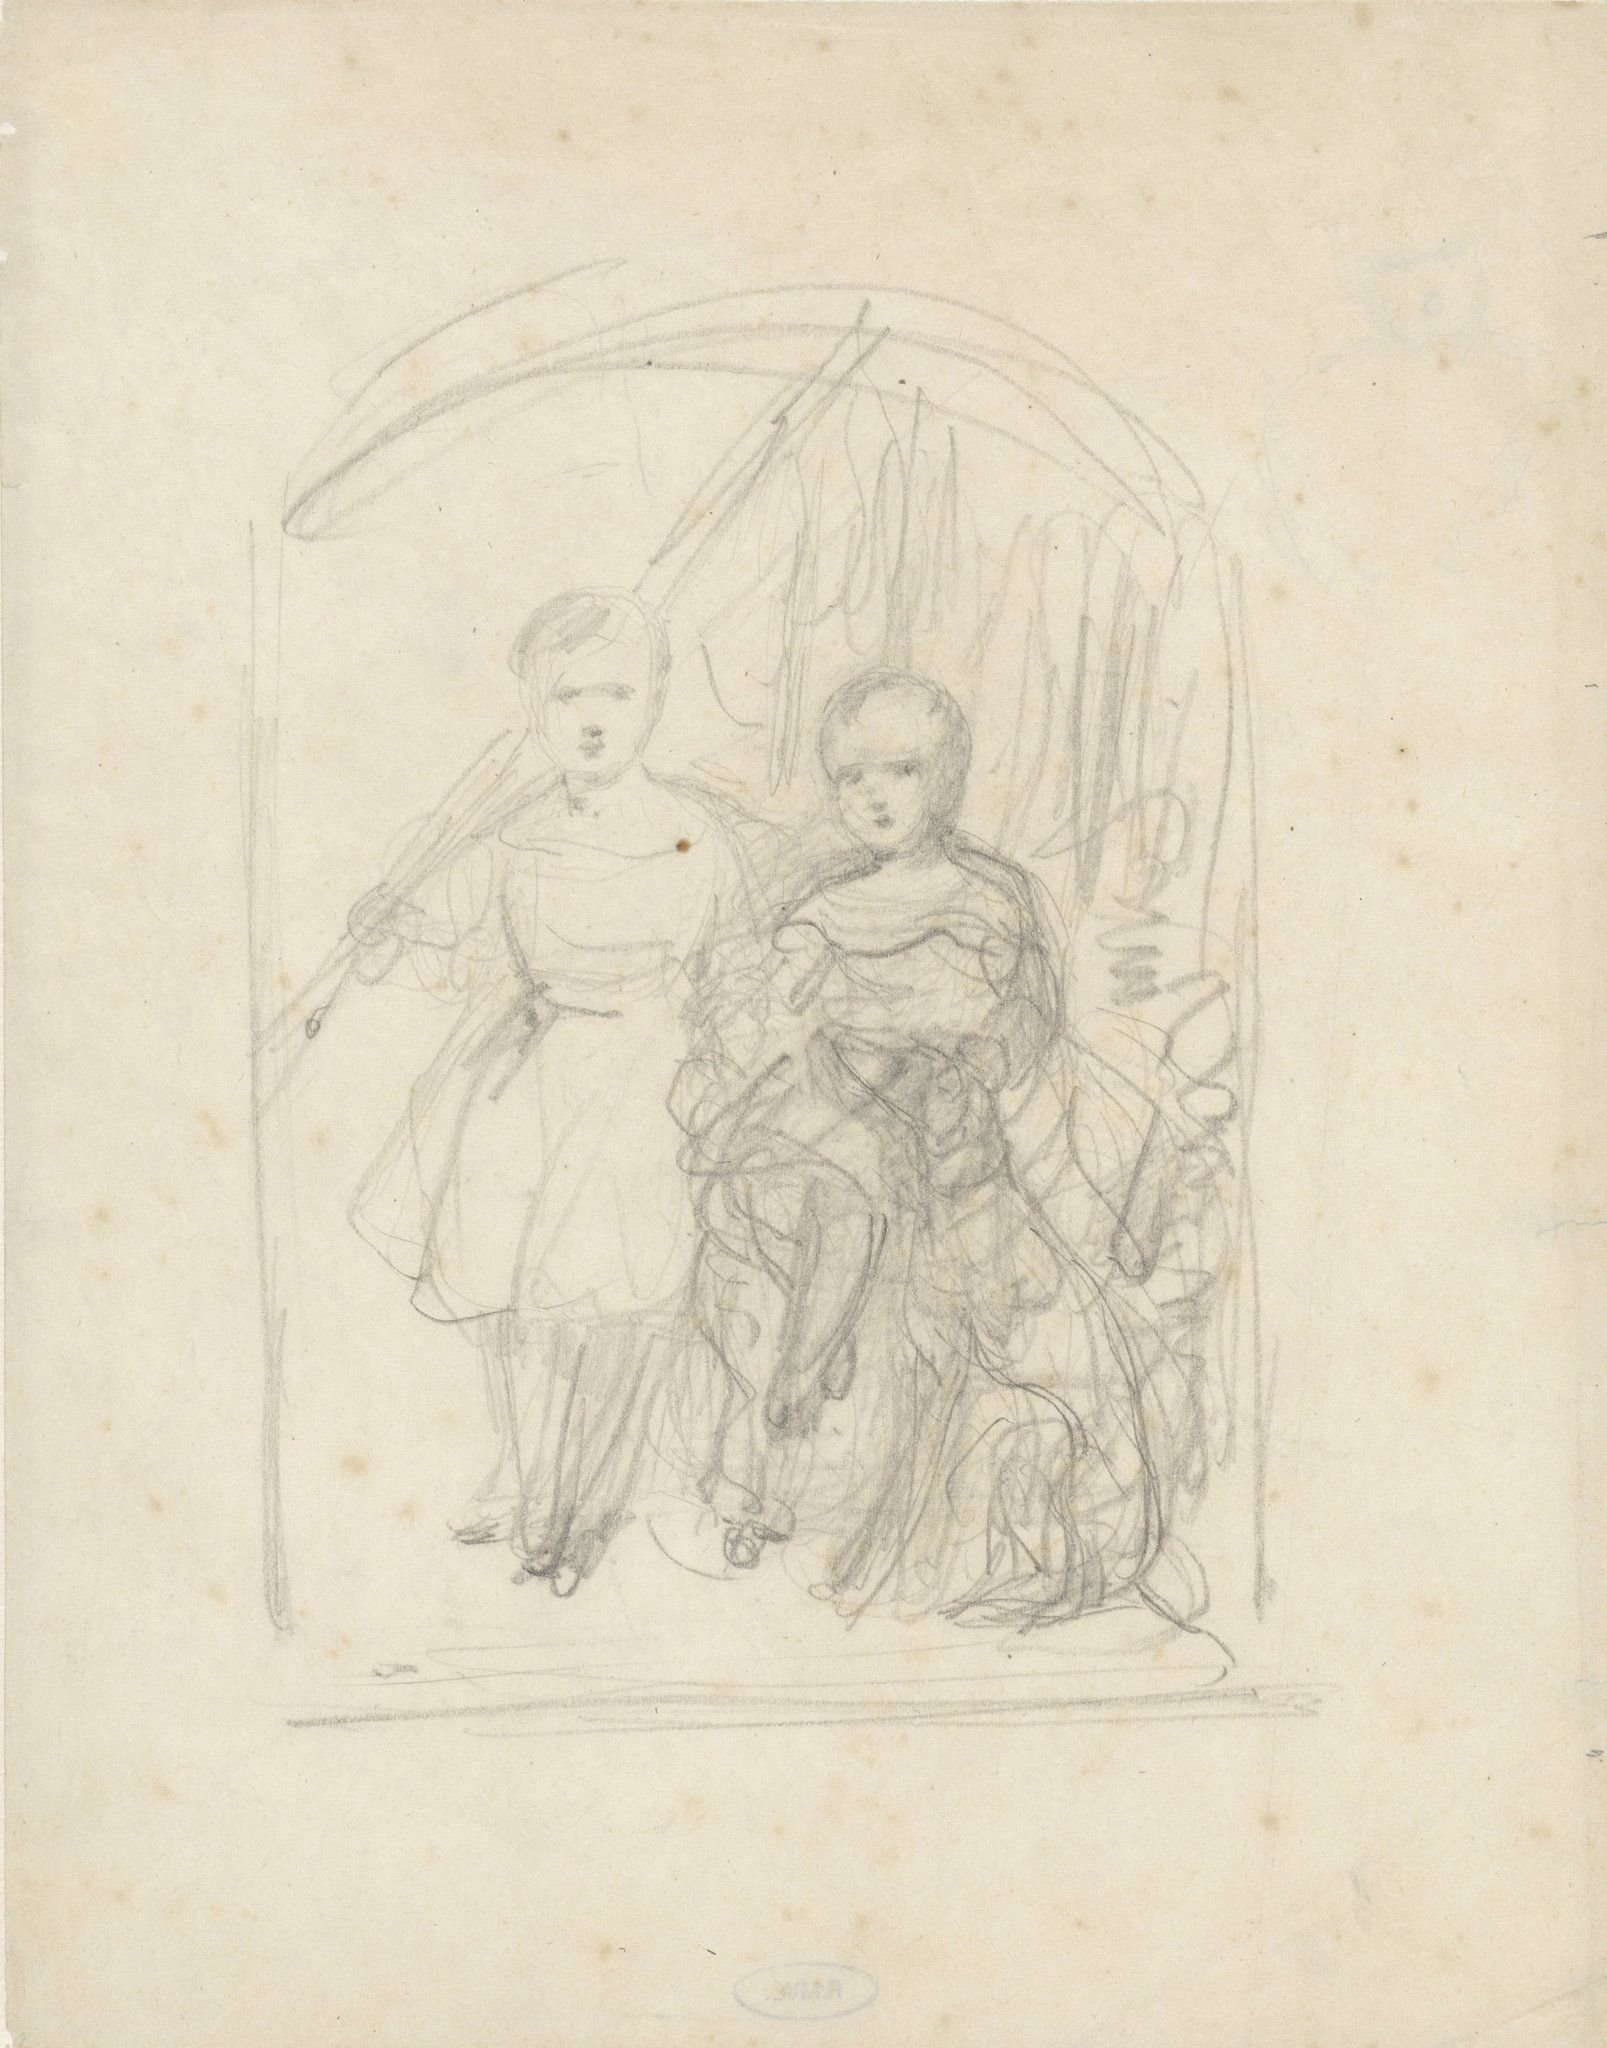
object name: drawing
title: Studie voor het portret van de jonge prinsen Willem en Maurits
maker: nicolaas pieneman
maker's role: draughtsman, painter, print maker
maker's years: 1809-1860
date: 1847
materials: paper, pencil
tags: the hague, paris, willem (prins der nederlanden), historical persons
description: Voorstudie voor het dubbelportret van de jonge prinsen Willem en Maurits, zonen van de latere koning Willem III.